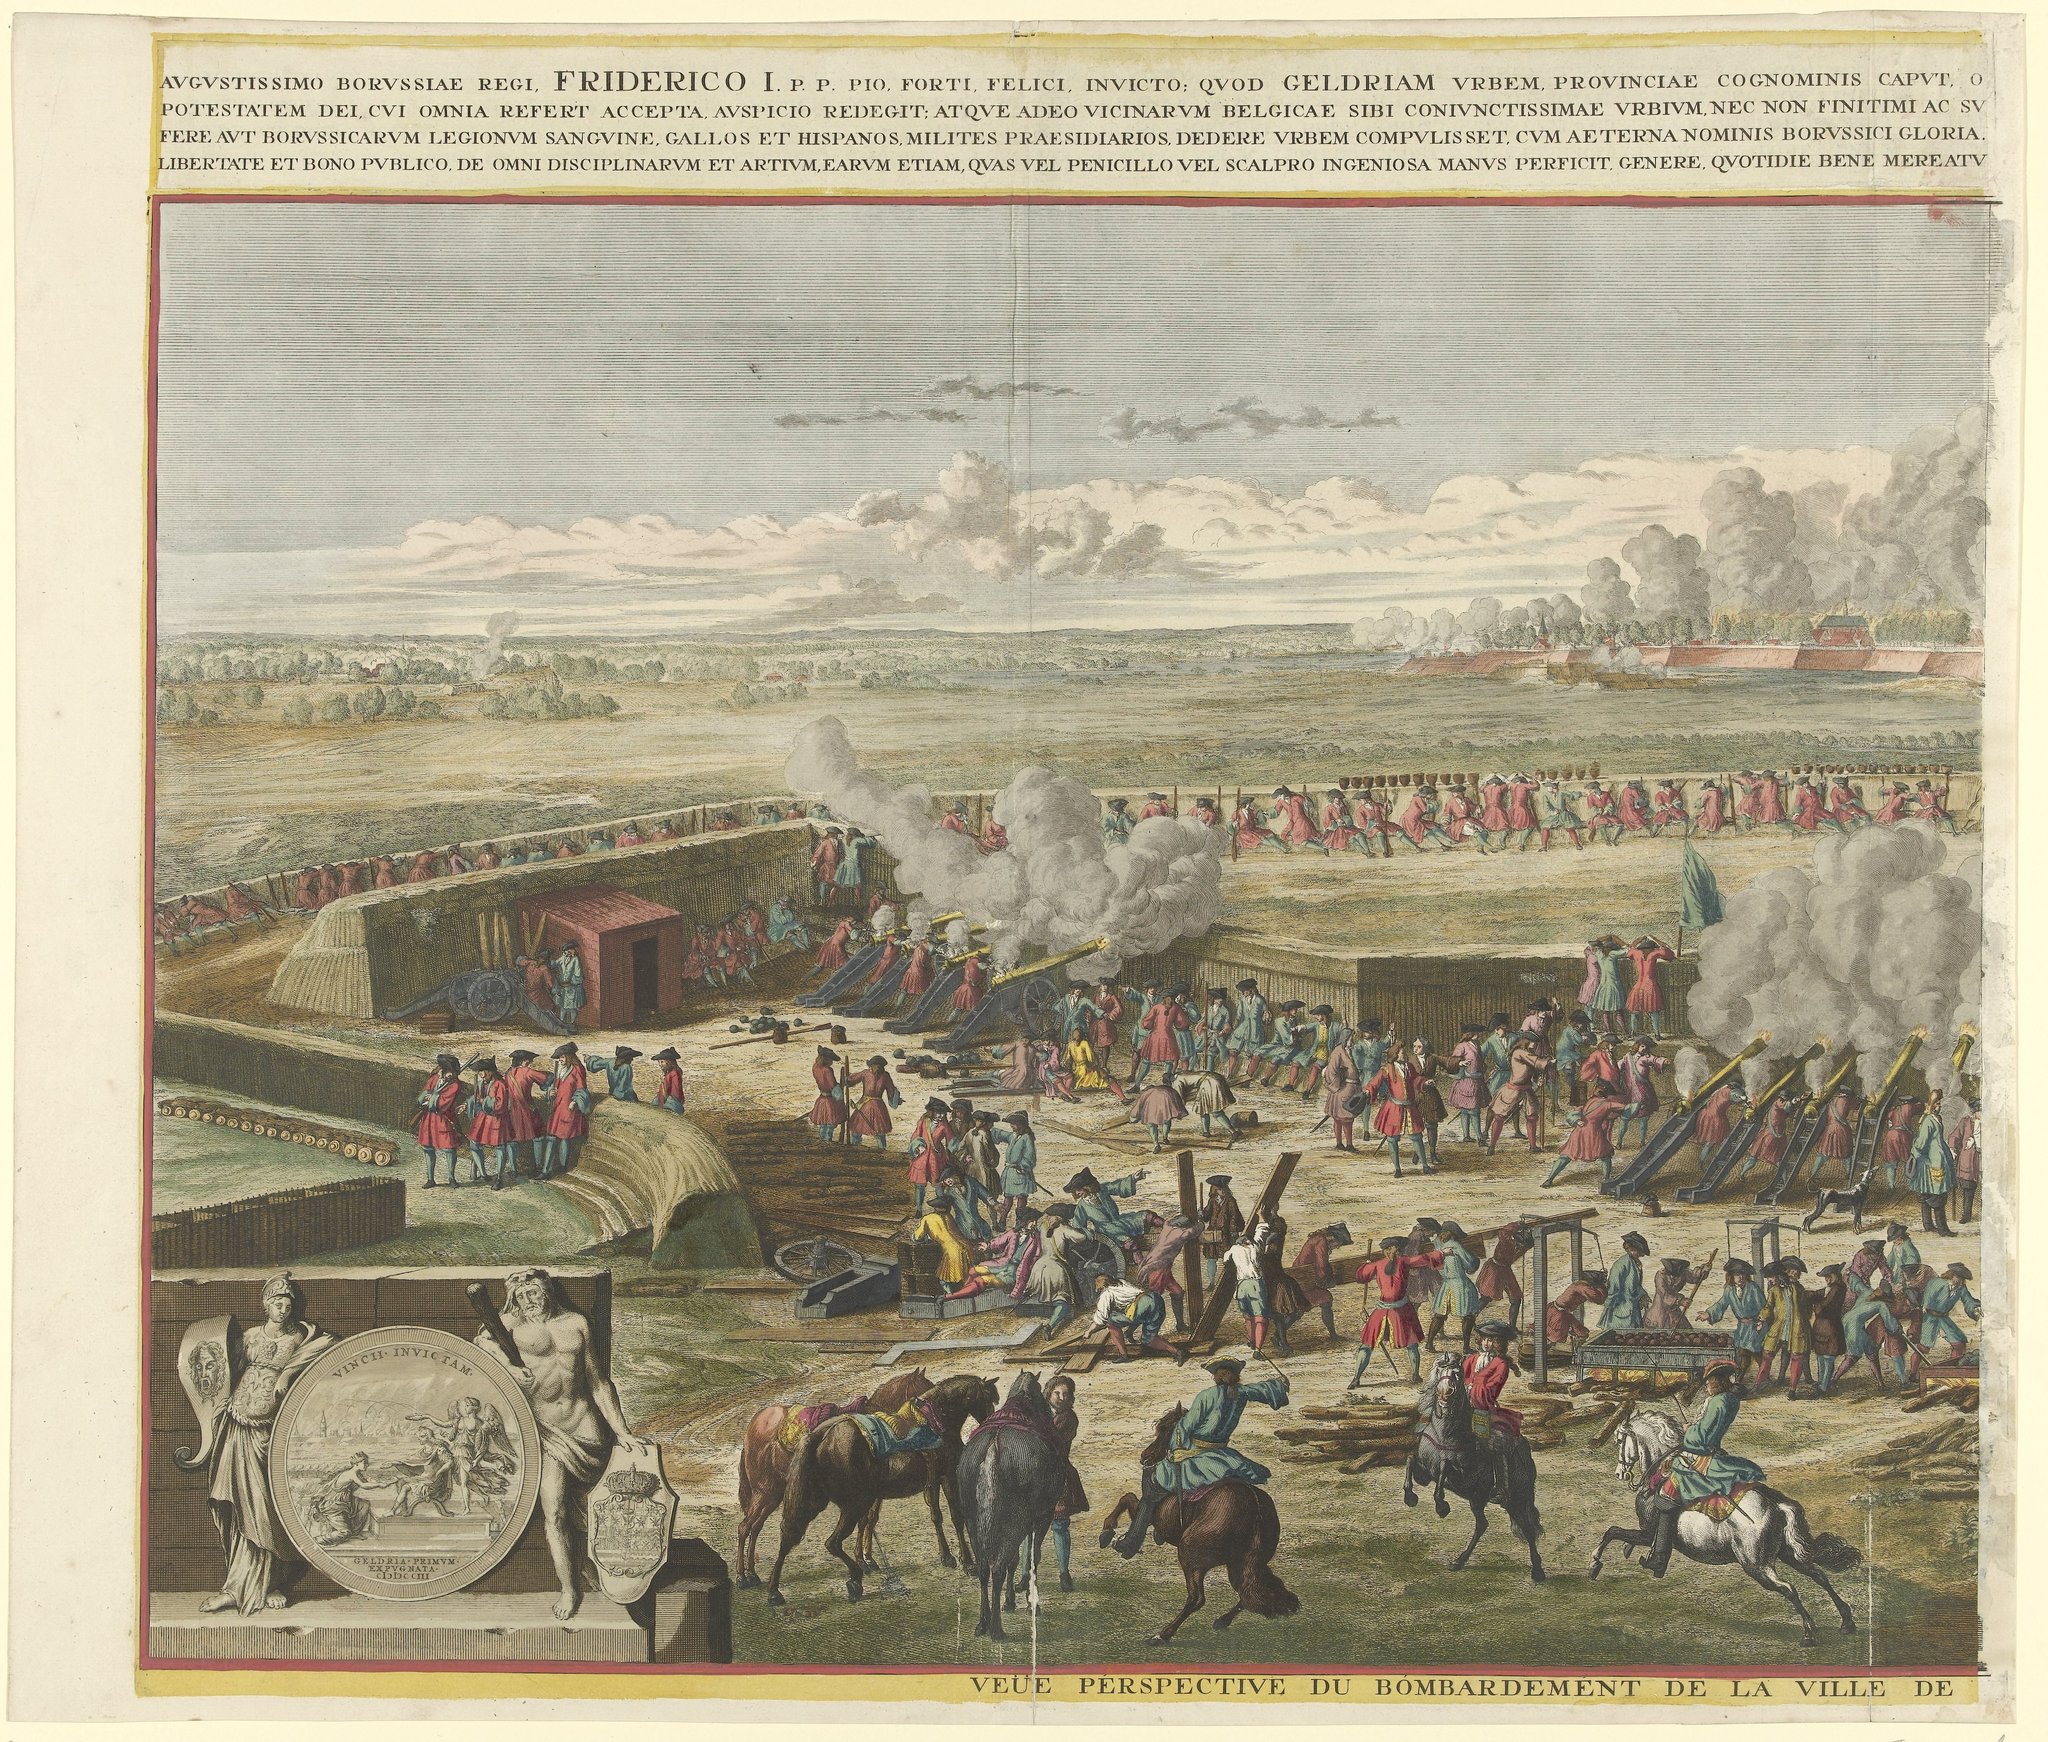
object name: print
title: Veue perspective du bombardement de la ville de Gueldre par un corps d'armée des troupes de sa maieste le roy de Prusse au mois d'octobre 1703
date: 1703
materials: paper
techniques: engraving, etching, hand coloring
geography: northern netherlands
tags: siege, position war, projectiles, explosives, etc., bombardment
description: Linker plaat van een grote prent van het bombardement van Geldern door de Pruisische troepen onder generaal Lotthum in de maand oktober 1703. Zeer brede voorstelling (gedrukt van drie platen) vanuit het kamp van de belegeraars waar kanonskogels worden gefabriceerd en afgeschoten. Staat vóór het nummer en de Nederlandse titel. Aan de bovenzijde is een strook geplakt met gegraveerde tekst in het Latijn waarin de opdracht staat. Zie RP-P-OB-83.394B voor het andere deel van de prent.